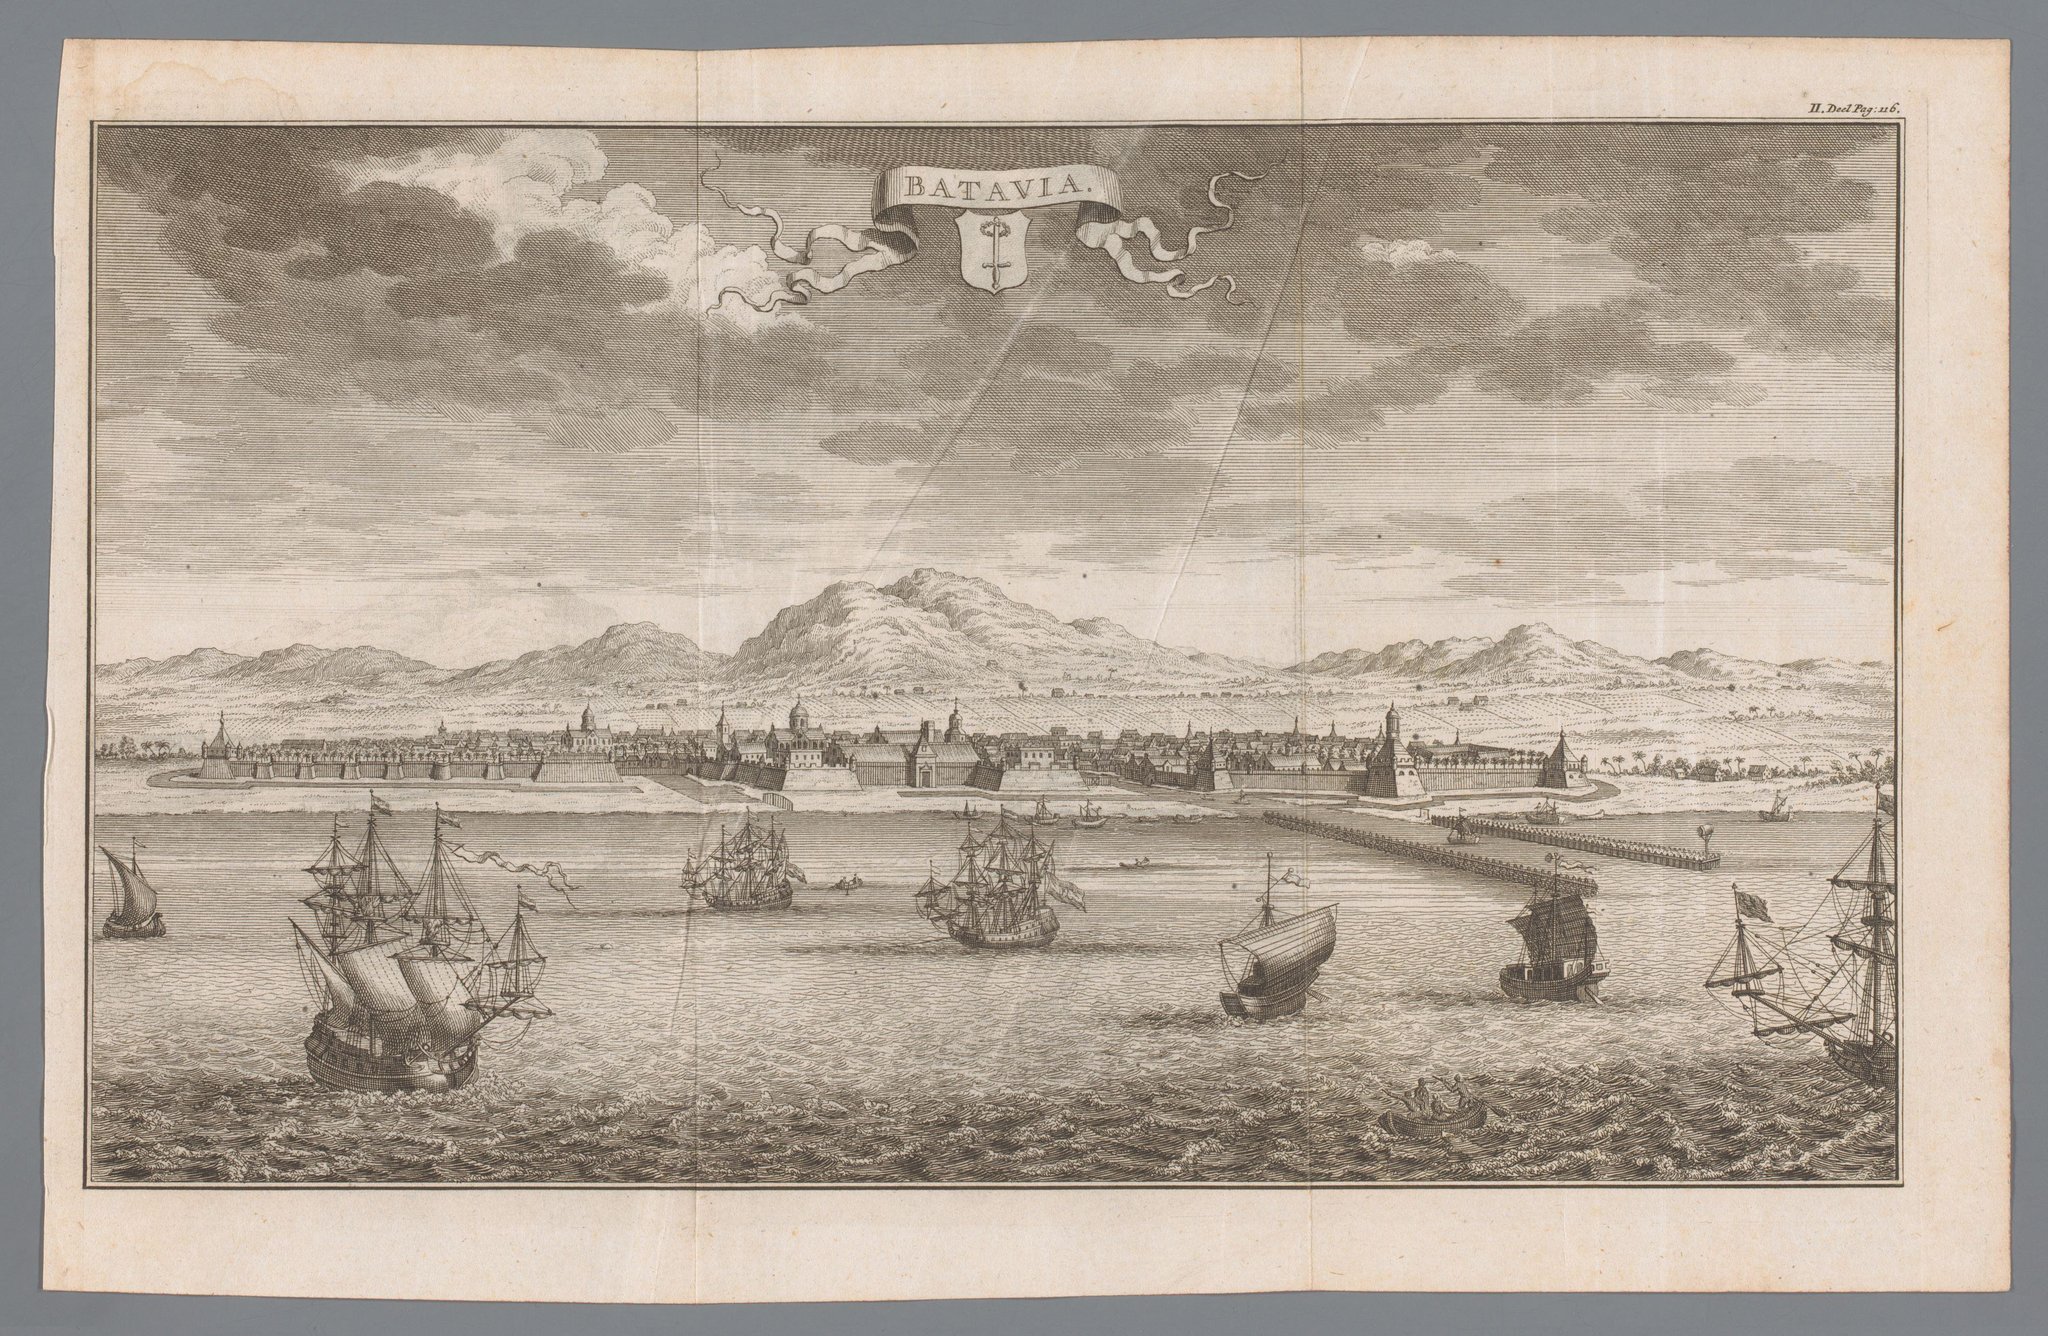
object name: book illustration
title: Gezicht op Batavia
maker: Anonymous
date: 1700-1799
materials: paper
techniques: engraving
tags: island (in tropical and sub-tropical regions), batavia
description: Gezicht in vogelvlucht op Batavia, vanuit zee. Schepen, waaronder VOC-zeilschepen, op de voorgrond. De titel in een banier bovenin, met daaronder het wapen van Batavia. Rechts bovenin: II. Deel Pag. 116.